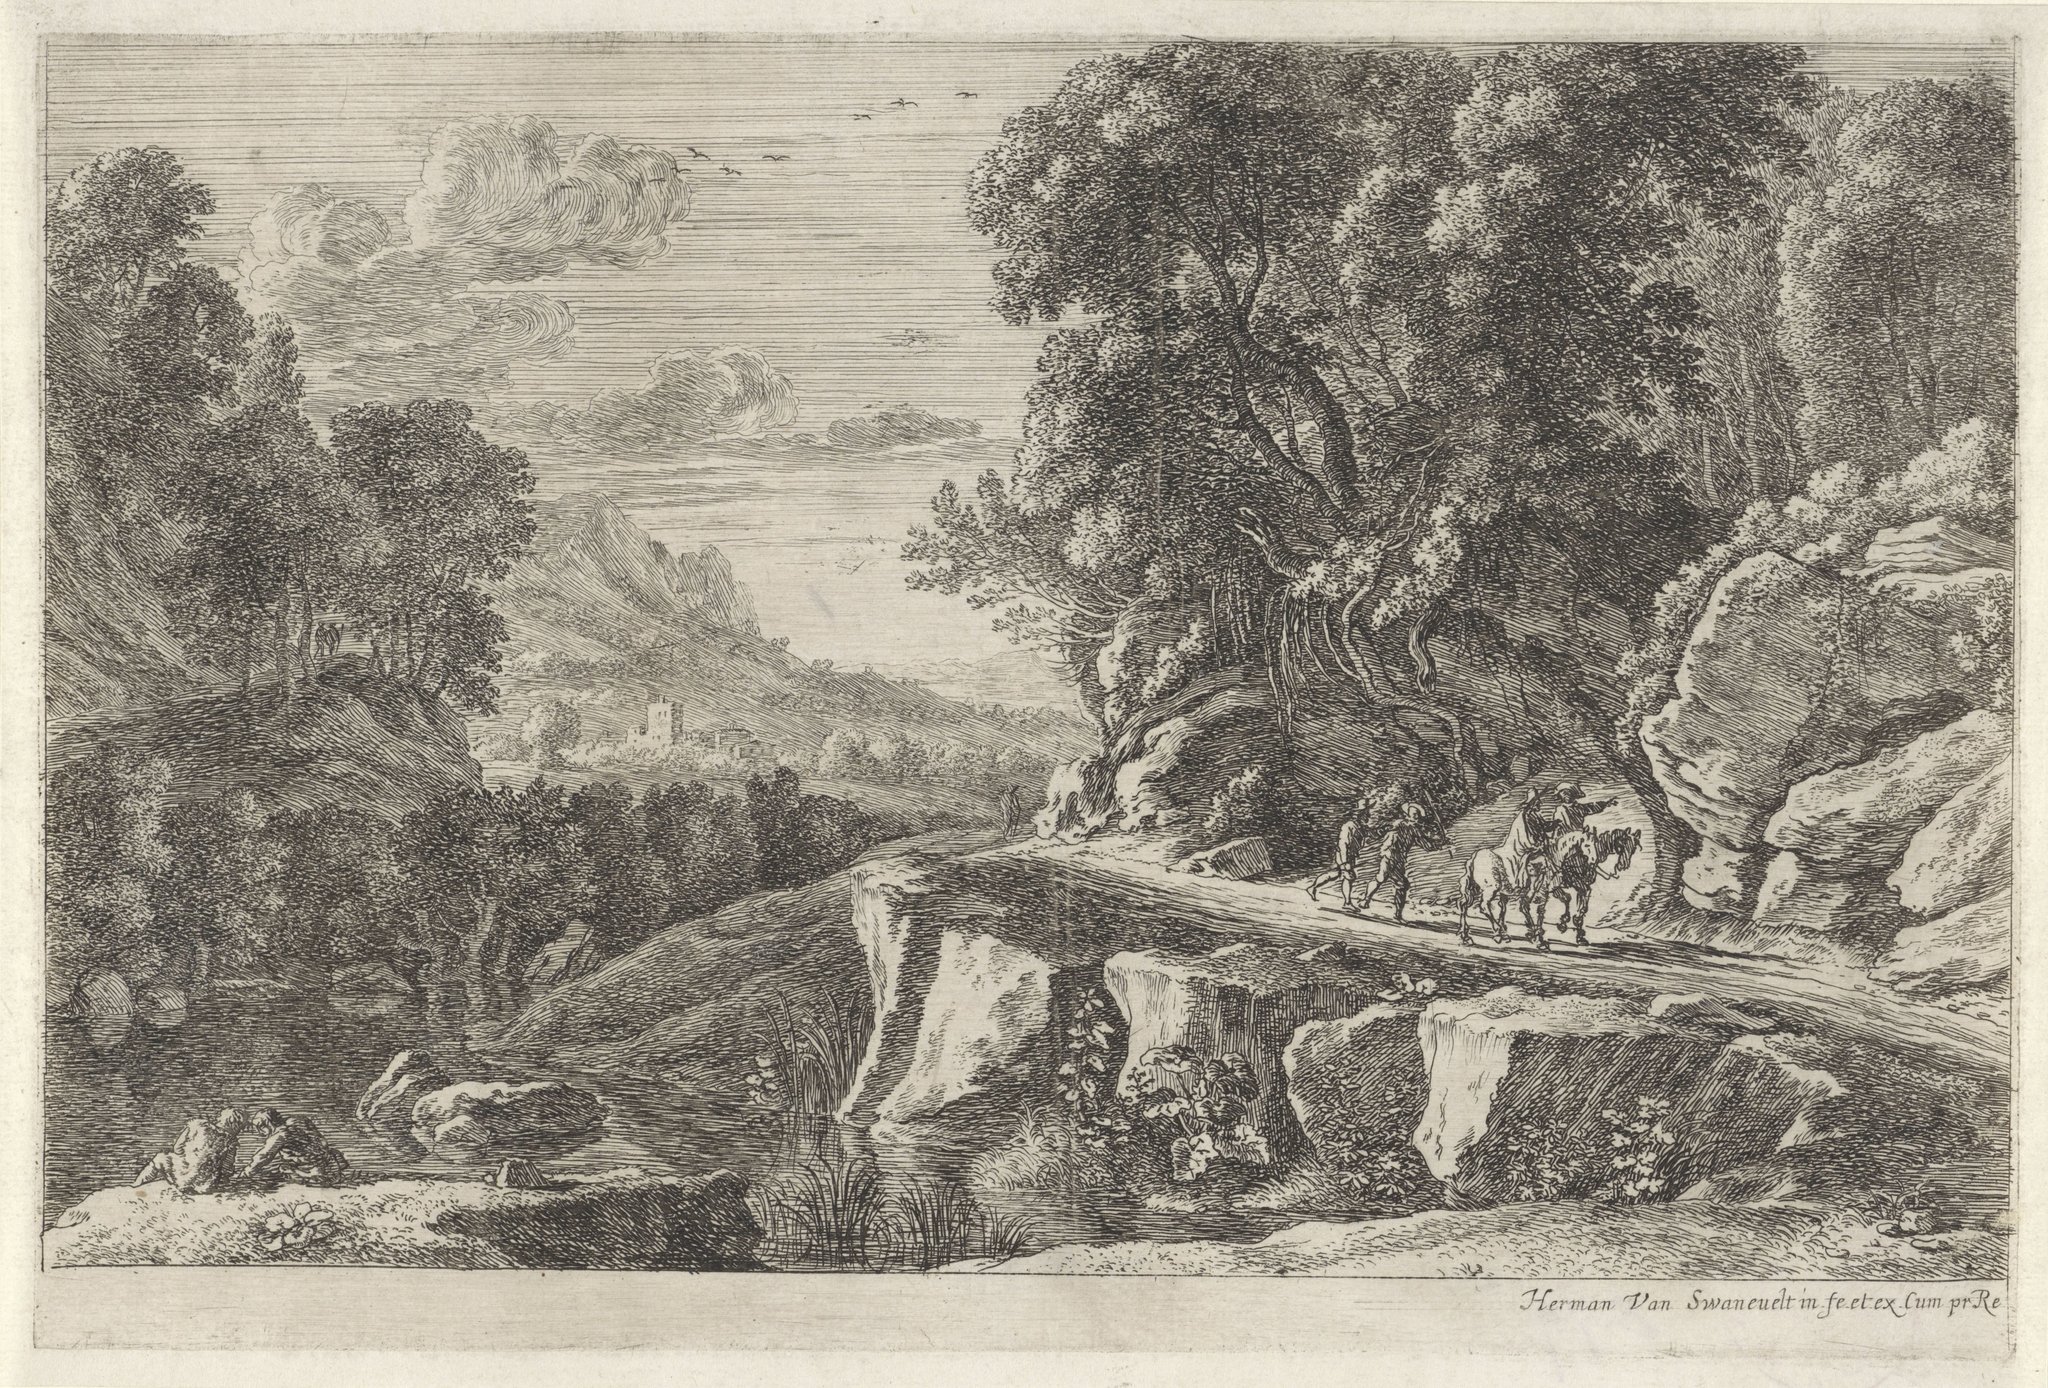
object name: print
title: Landschap met twee ruiters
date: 1650-1655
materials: paper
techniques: etching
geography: paris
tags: riding a horse, ass, or mule; rider, horseman, river, rural housing, e.g. country-house, villa, cottage, 'en route', traveller under way, mountains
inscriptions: collector's mark: Lugt 240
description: Op een pad in een bergachtig landschap rijden twee ruiters. Achter hen lopen enkele figuren. Vooraan links zitten twee figuren bij een rivier.